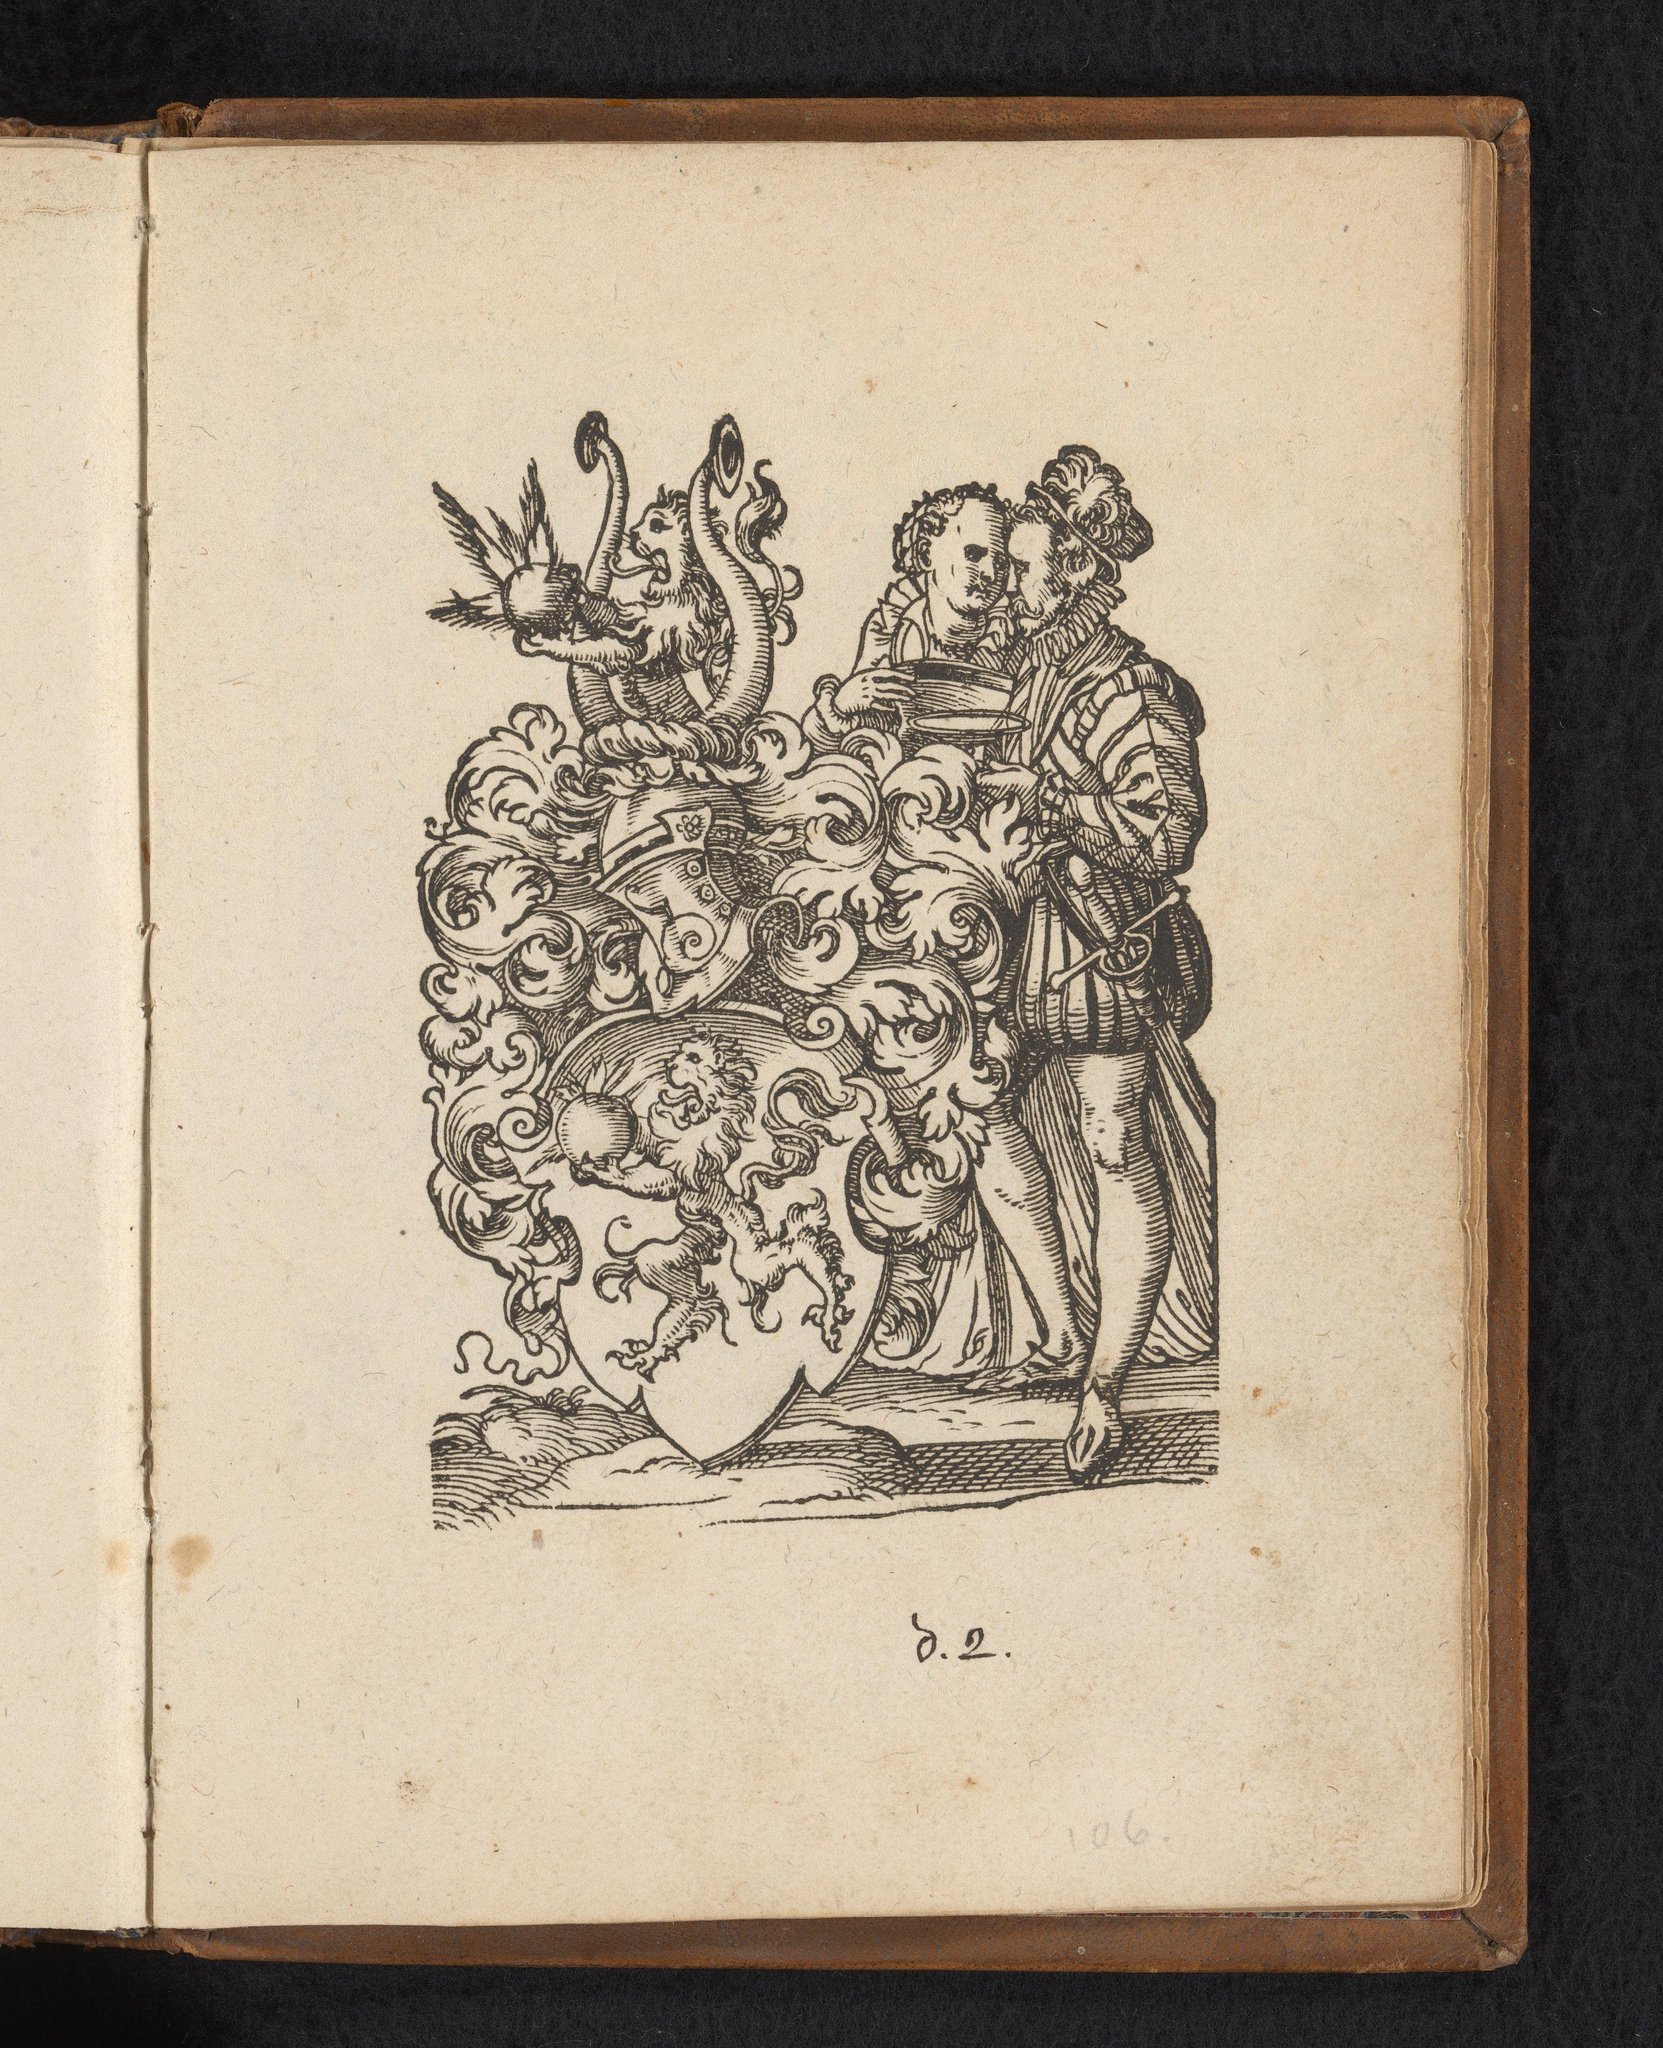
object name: print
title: Man en vrouw met het wapen van Sigmund Feyerabend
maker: Anonymous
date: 1578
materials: paper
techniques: woodcut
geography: nuremberg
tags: print maker, printer, publisher, bookseller, sigmund feyerabend, couple of lovers, armorial bearing, heraldry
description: Een man en een vrouw staande bij een wapenschild met een leeuw, het wapen van Sigmund Feyerabend. Onderdeel van het modelboek Enchiridion artis pingendi, fingendi & sculpendi met 108 figuren bedoeld voor beginnende schilders, beeldhouwers en prentmakers.